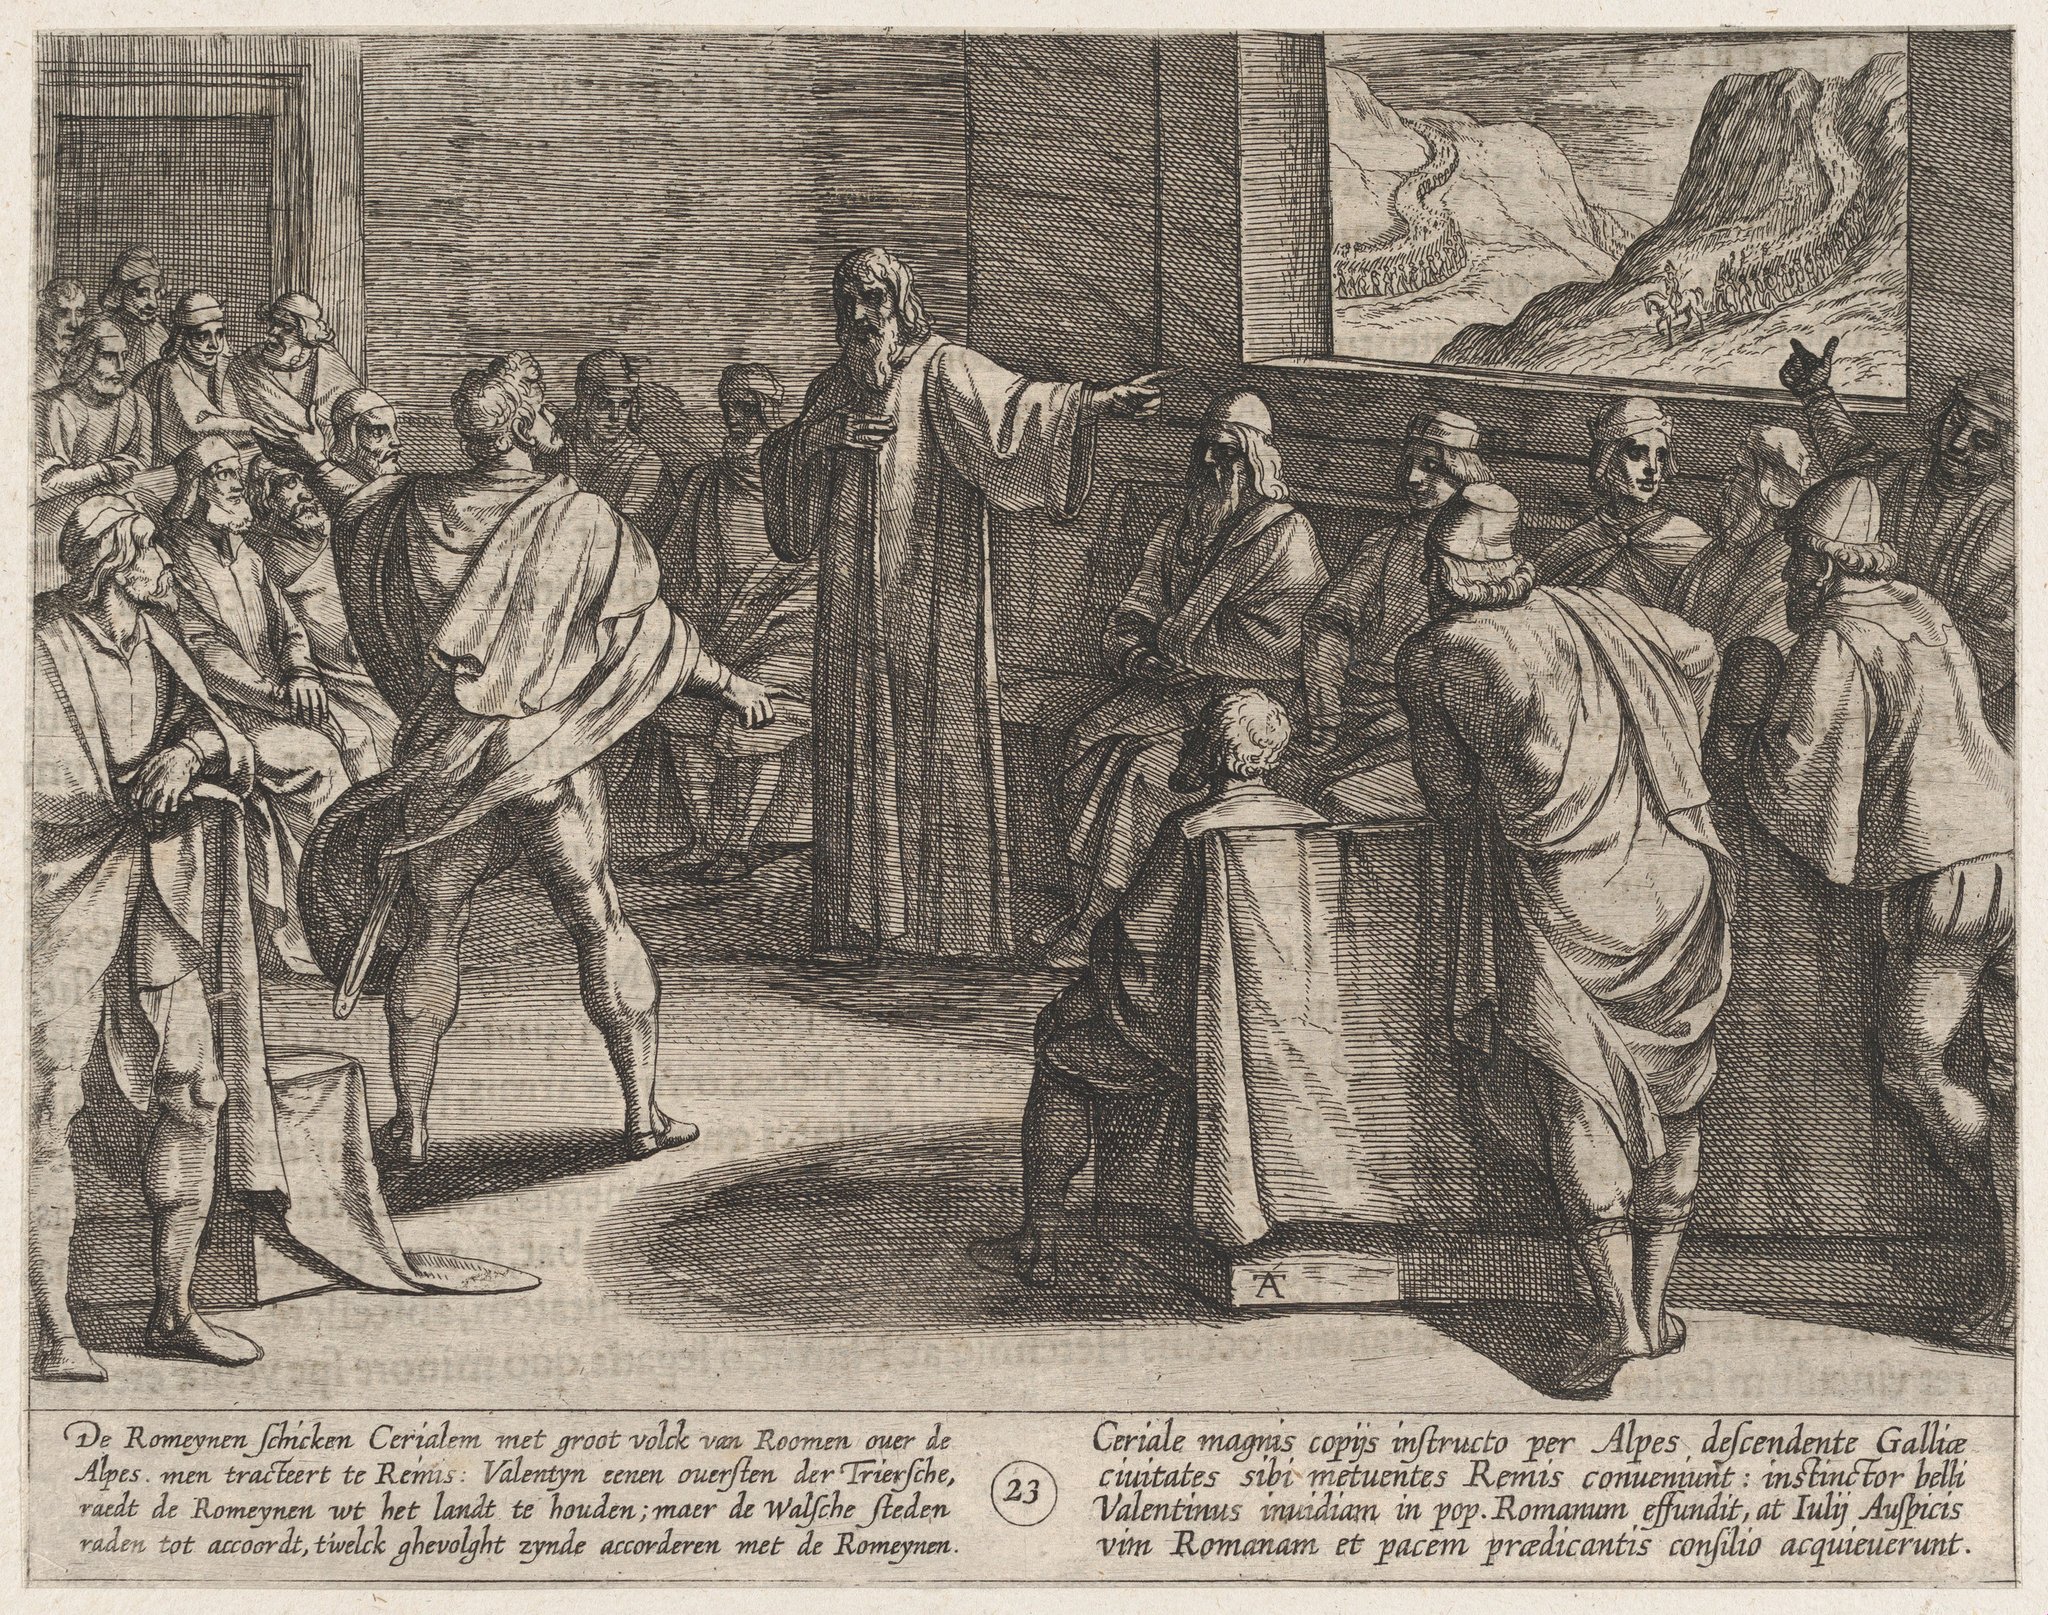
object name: print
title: Plate 23: Conference on What Steps to Take Upon the Romans' New Troops Approaching Across the Alps, from The War of the Romans Against the Batavians (Romanorvm et Batavorvm societas)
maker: antonio tempesta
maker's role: artist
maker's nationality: italian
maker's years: 1555-1630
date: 1611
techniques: etching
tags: men